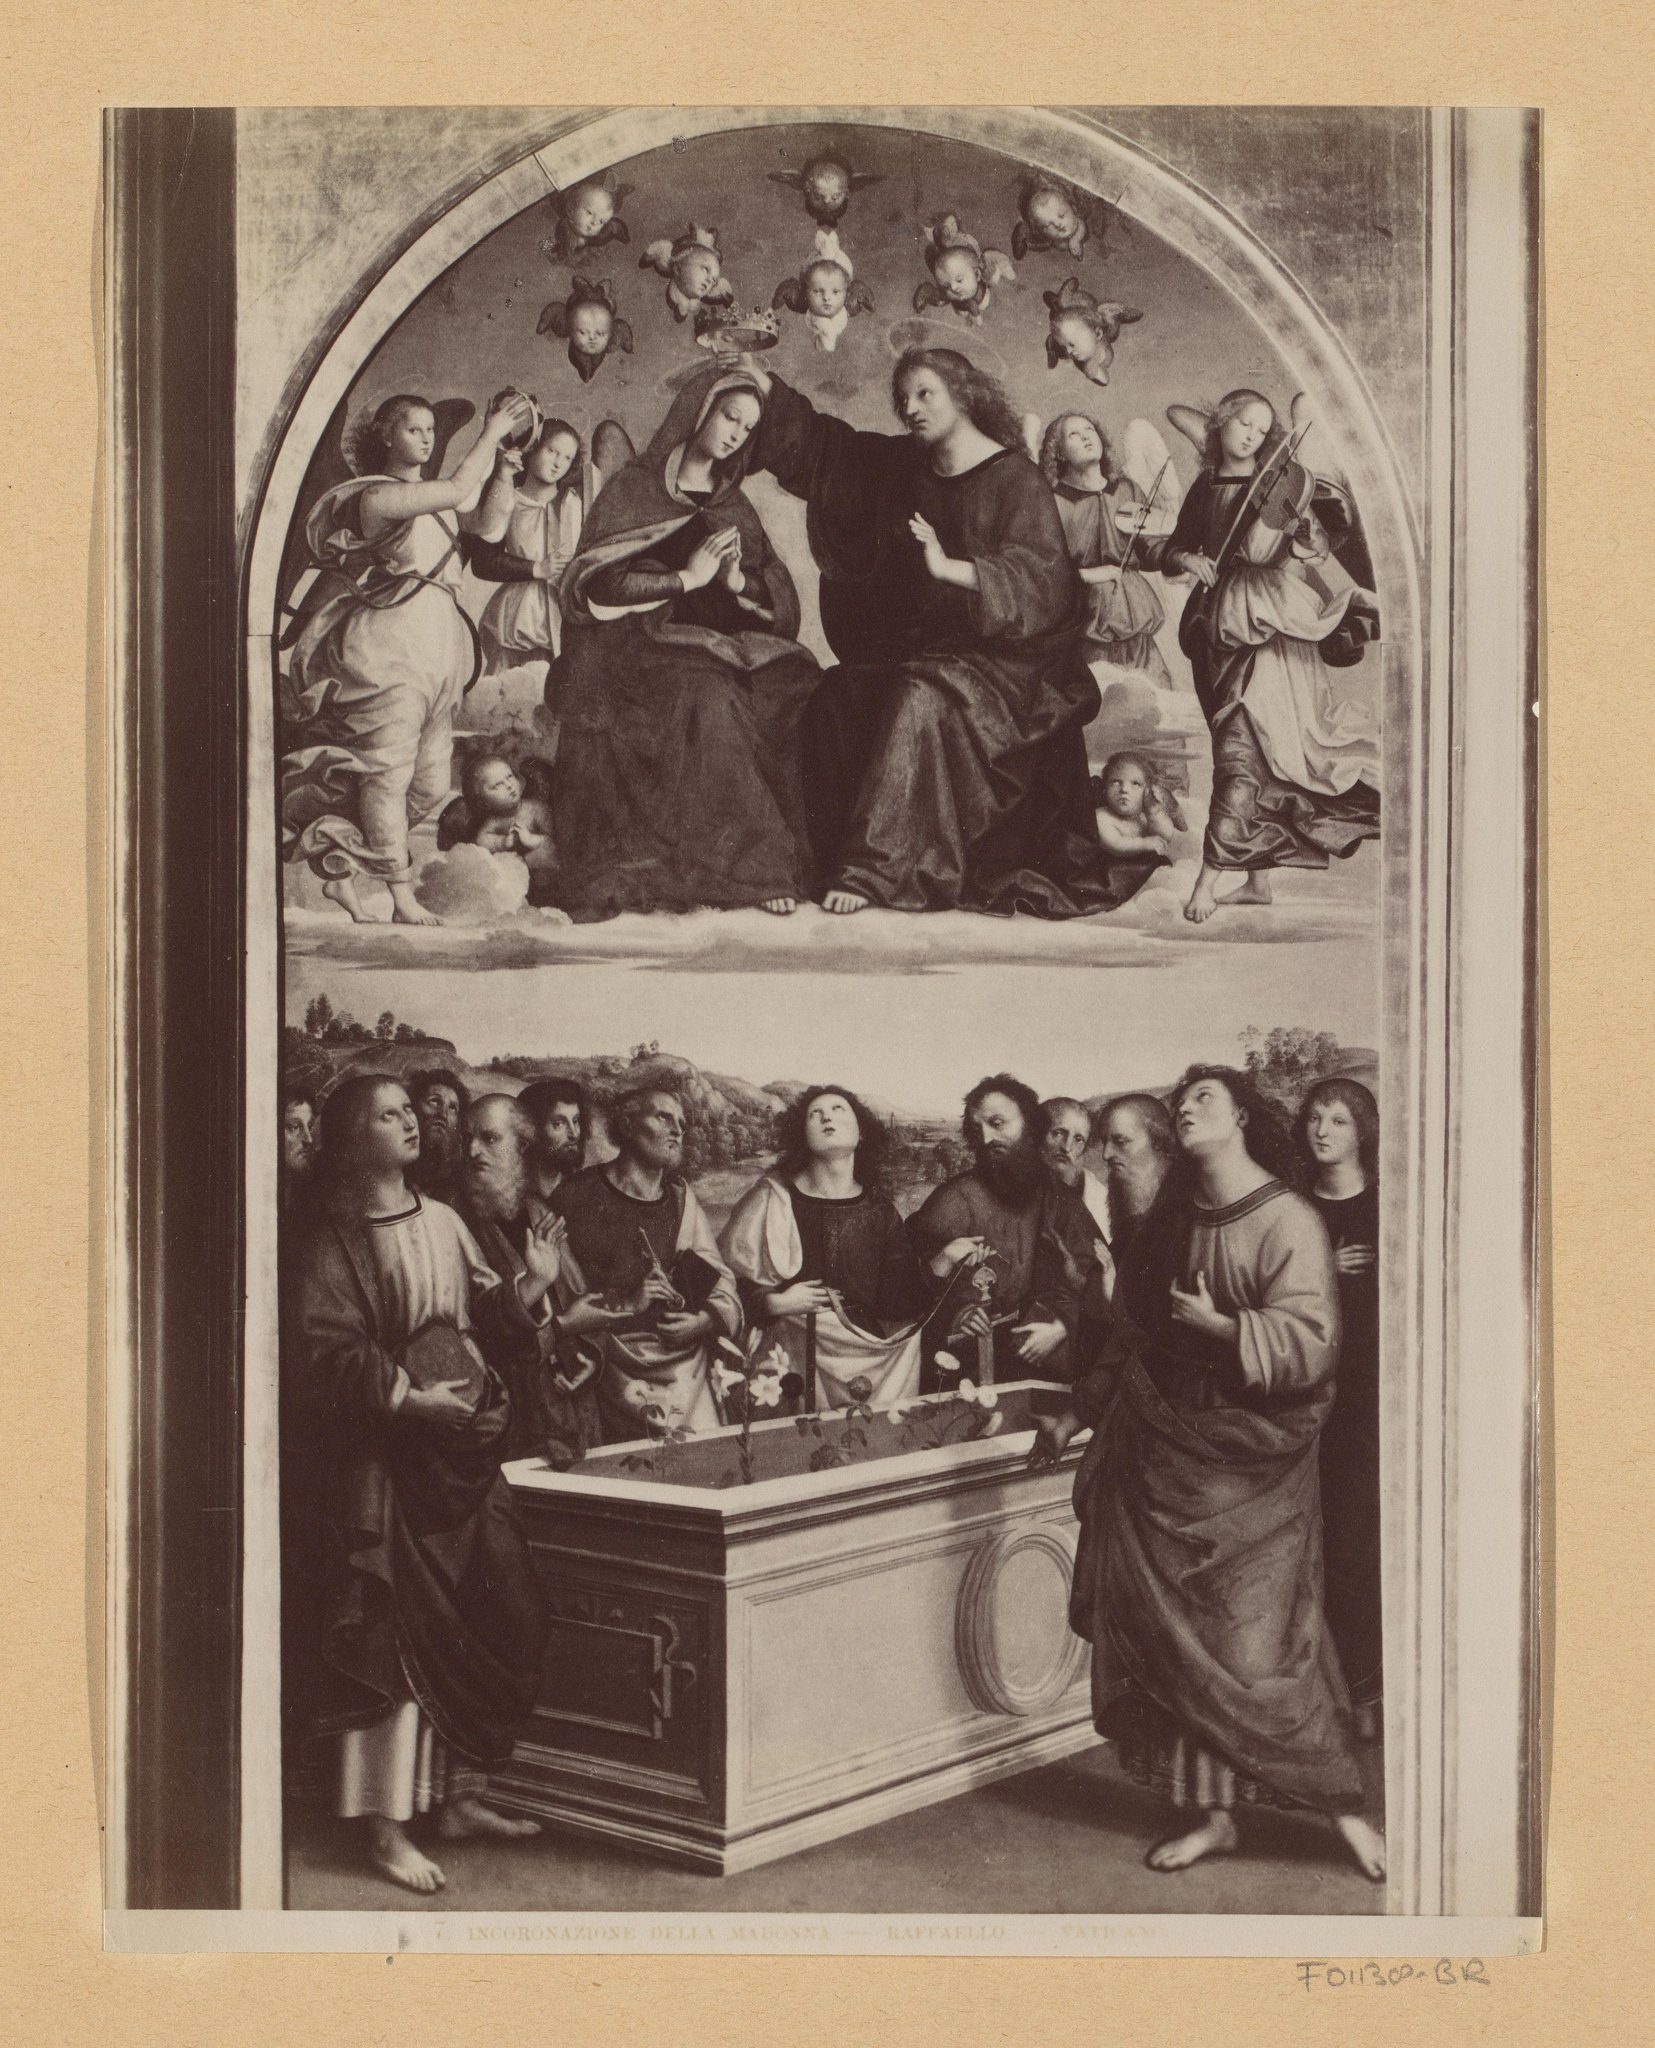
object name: photograph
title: Fotoreproductie van een schilderij door Rafaël, voorstellend de kroning van Maria (Oddi altaarstuk)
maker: Anonymous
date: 1860-1900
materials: photographic support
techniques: albumen print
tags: coronation of mary in heaven (usually the holy trinity present)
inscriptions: number: ‘7’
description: Onderdeel van Reisalbum met opnames van kunstwerken en bezienswaardigheden in Italië, Griekenland en Frankrijk.